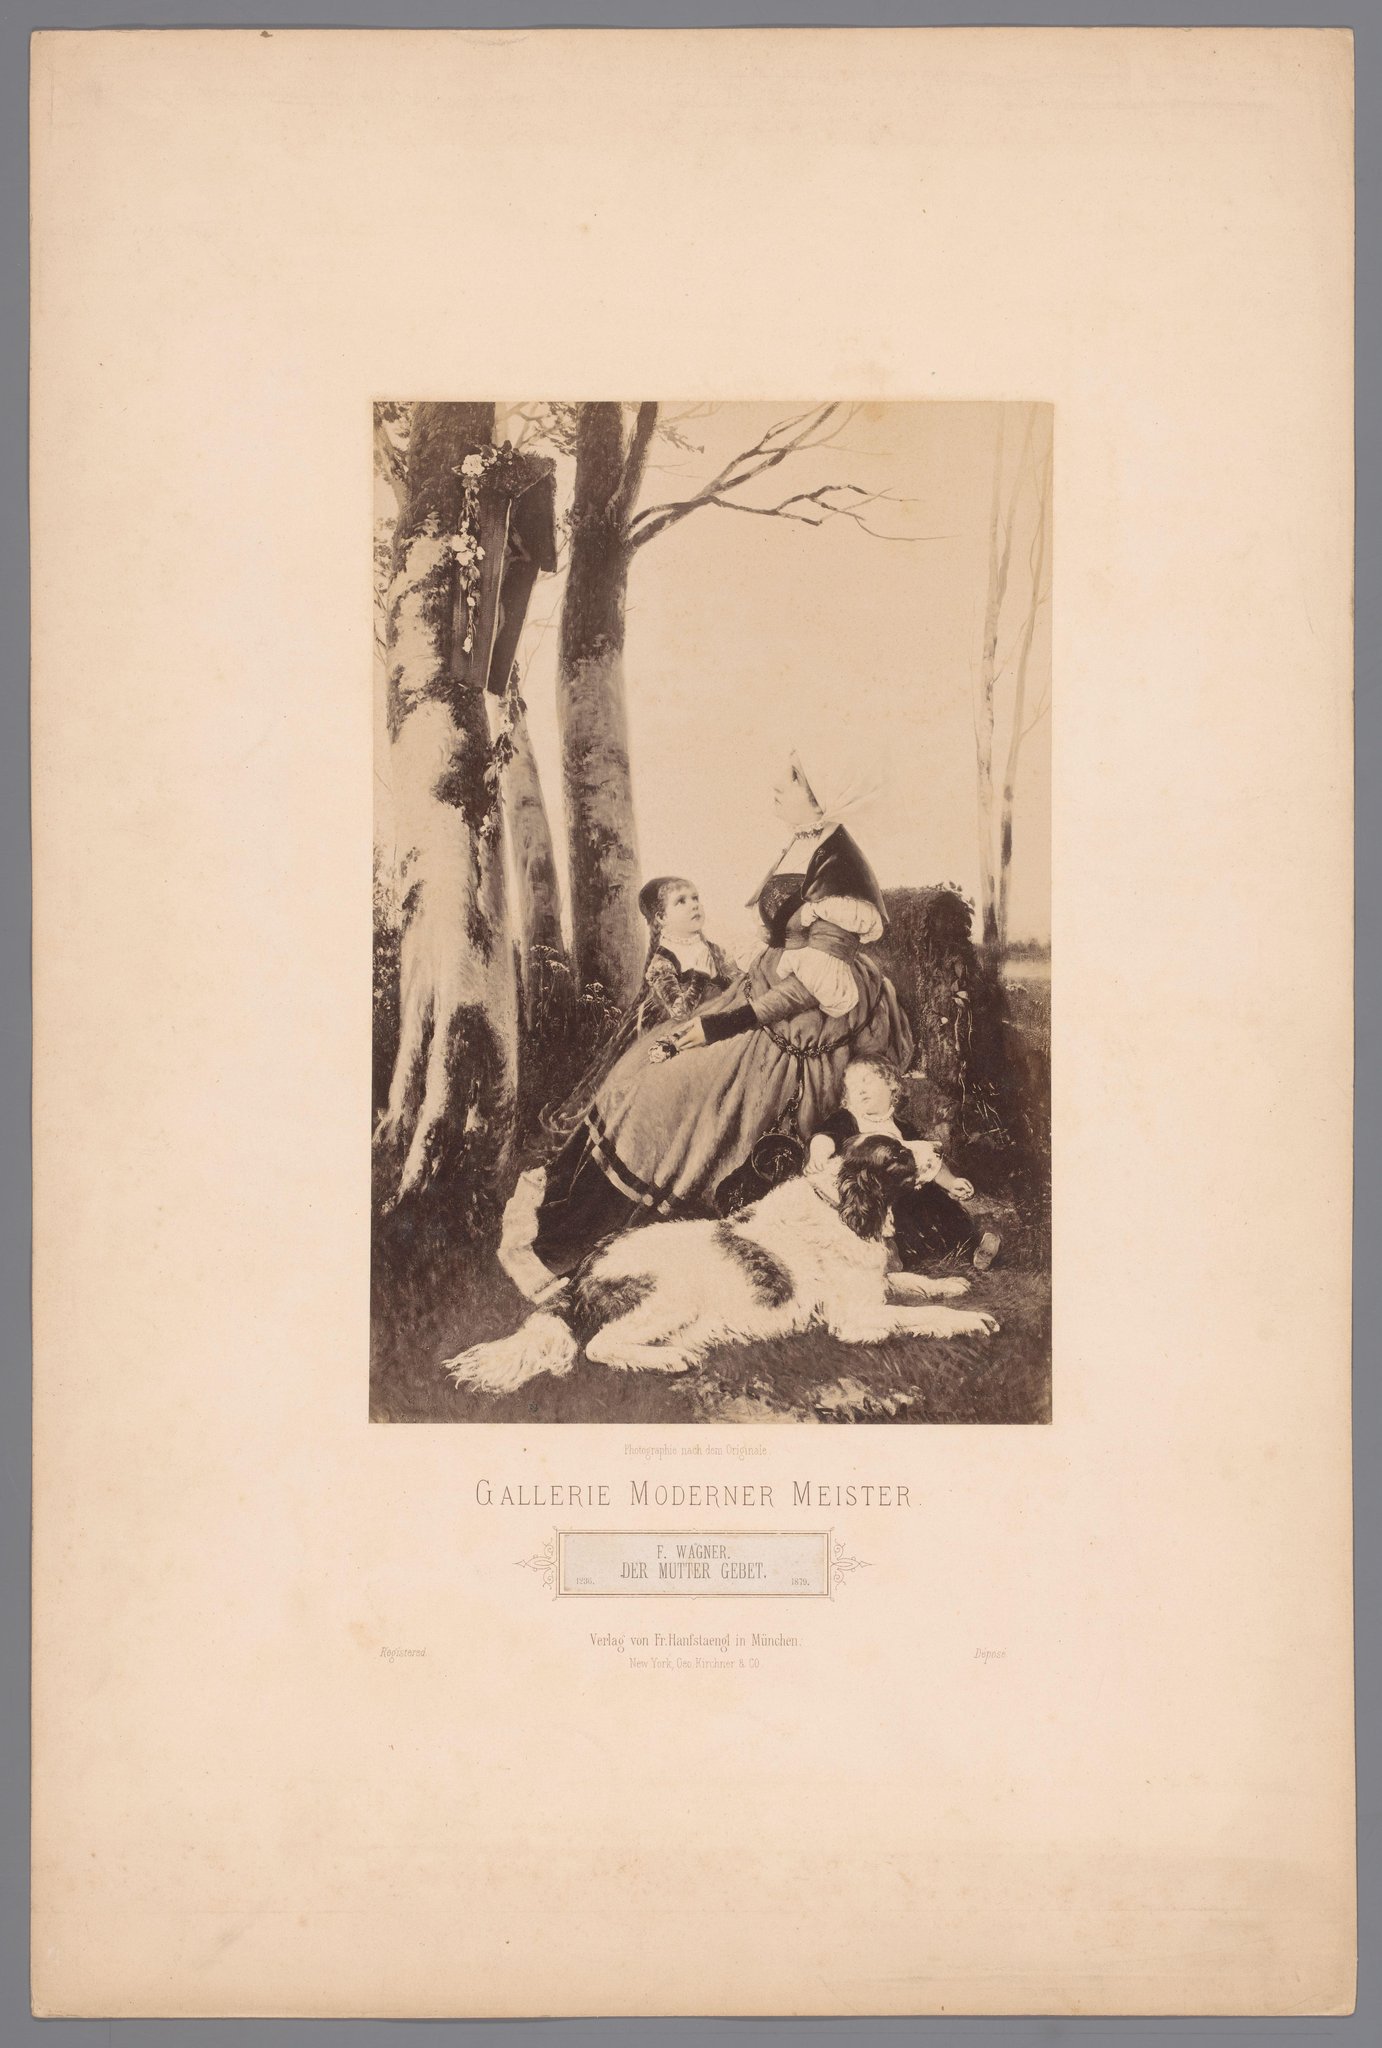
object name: photograph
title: Gallerie Moderner Meister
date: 1879-1900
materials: cardboard, paper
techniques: albumen print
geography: munich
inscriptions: caption: ‘Photographie nach dem Originale.//GALLERIE MODERNER MEISTER//F. WAGNER//DER MUTTER GEBET//Verlag von Fr. Hanfstaengl in München//New York, Geo Kirchner & Co..//Registered//Déposé’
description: Genretafereel van moeder met twee kinderen en een hond, biddend voor een kruisbeeld aan een boom